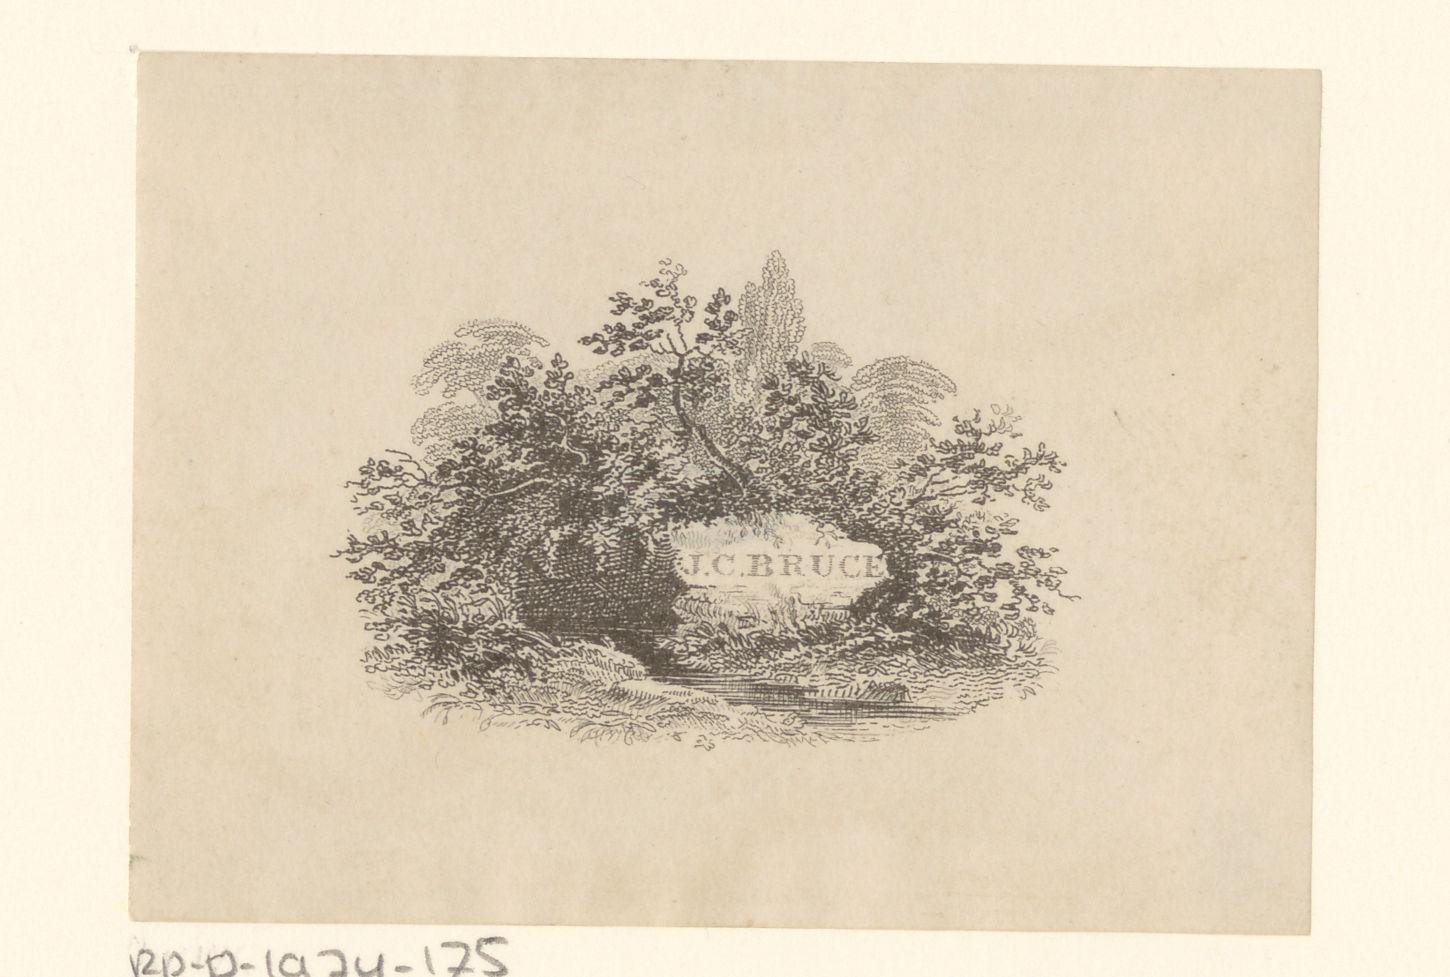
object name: print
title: Ex libris van J.C. Bruce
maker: thomas bewick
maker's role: draughtsman, painter, print maker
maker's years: 1753-1828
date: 1768-1828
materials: paper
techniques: etching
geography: great britain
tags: shrubs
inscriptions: collector's mark: Lugt 2228